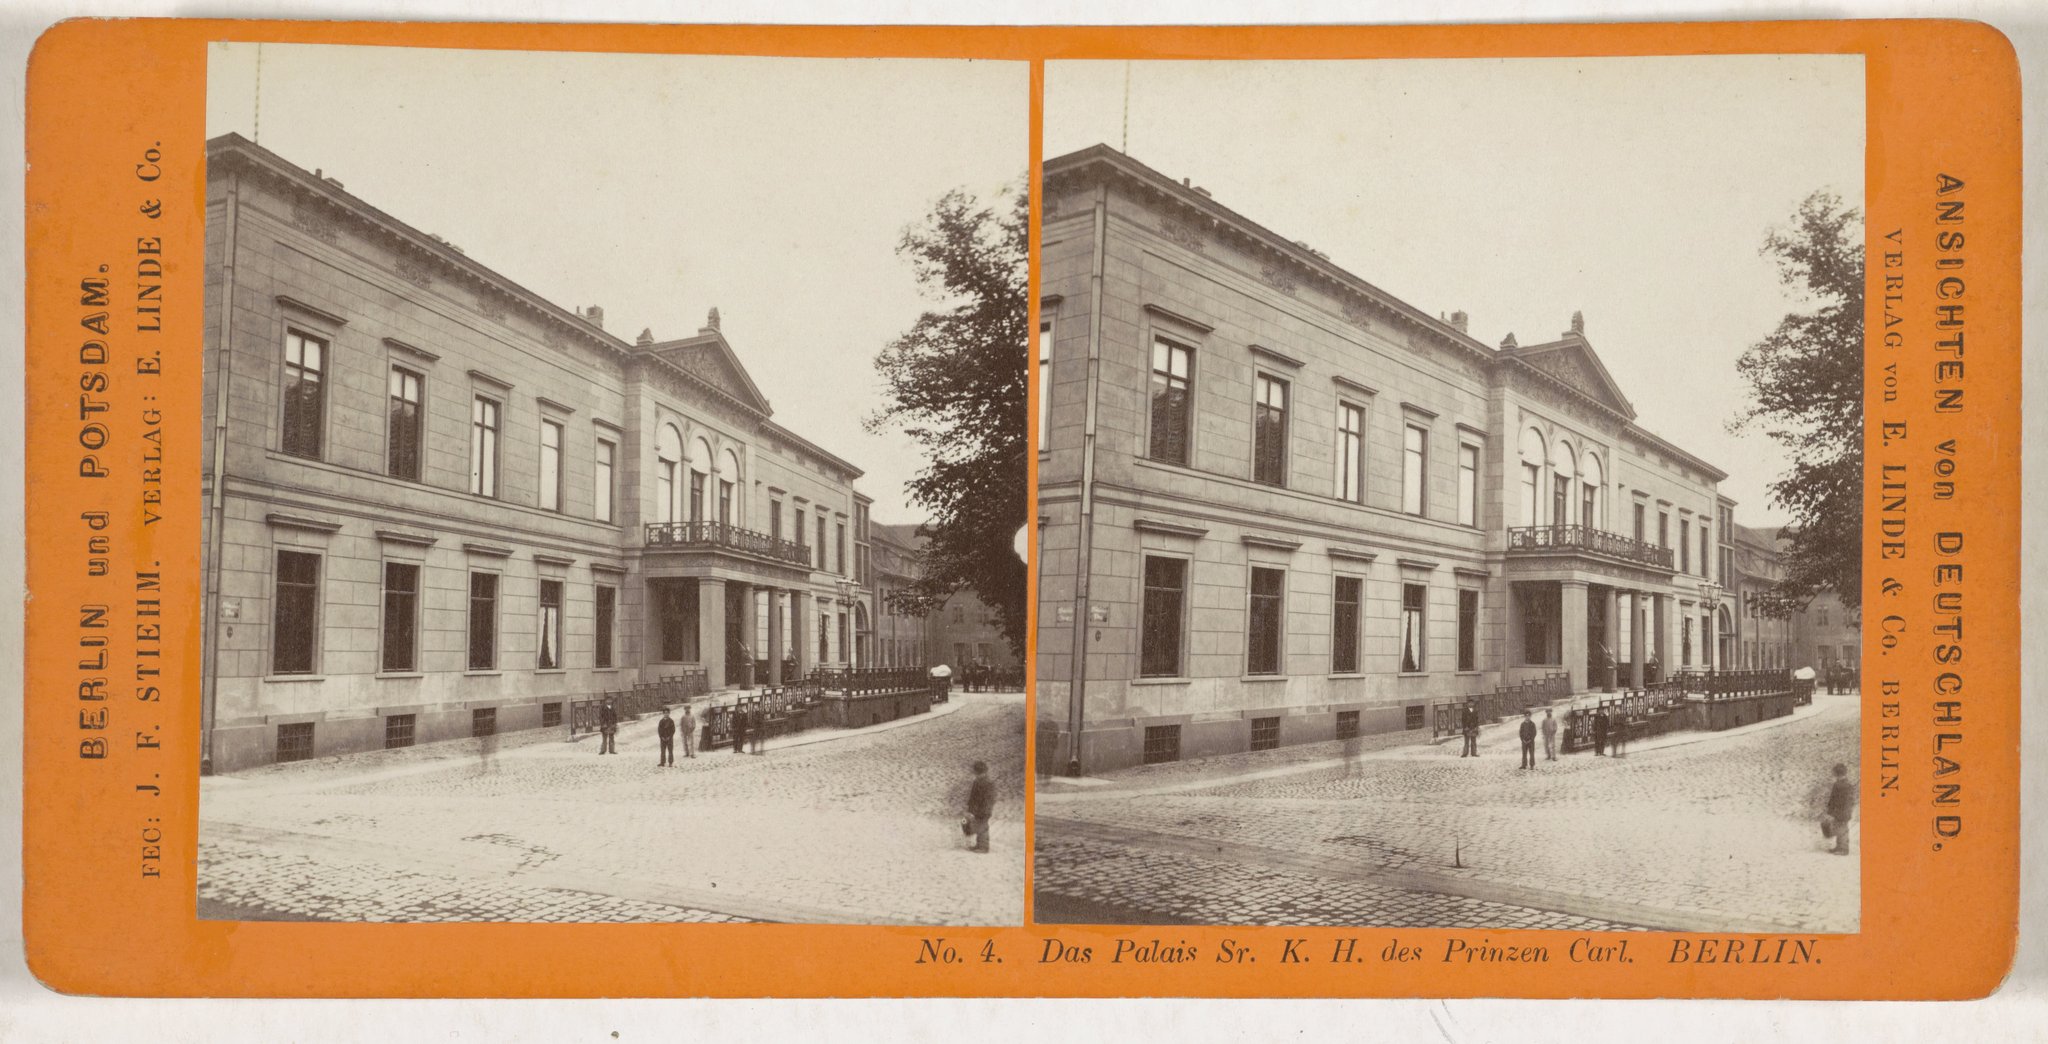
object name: stereograph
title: Ansichten von Deutschland / Berlin und Potsdam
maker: johann friedrich stiehm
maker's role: fotograaf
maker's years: 1826-1902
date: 1868-1870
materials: cardboard, paper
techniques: albumen print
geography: berlin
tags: palace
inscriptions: number: ‘No. 4.’